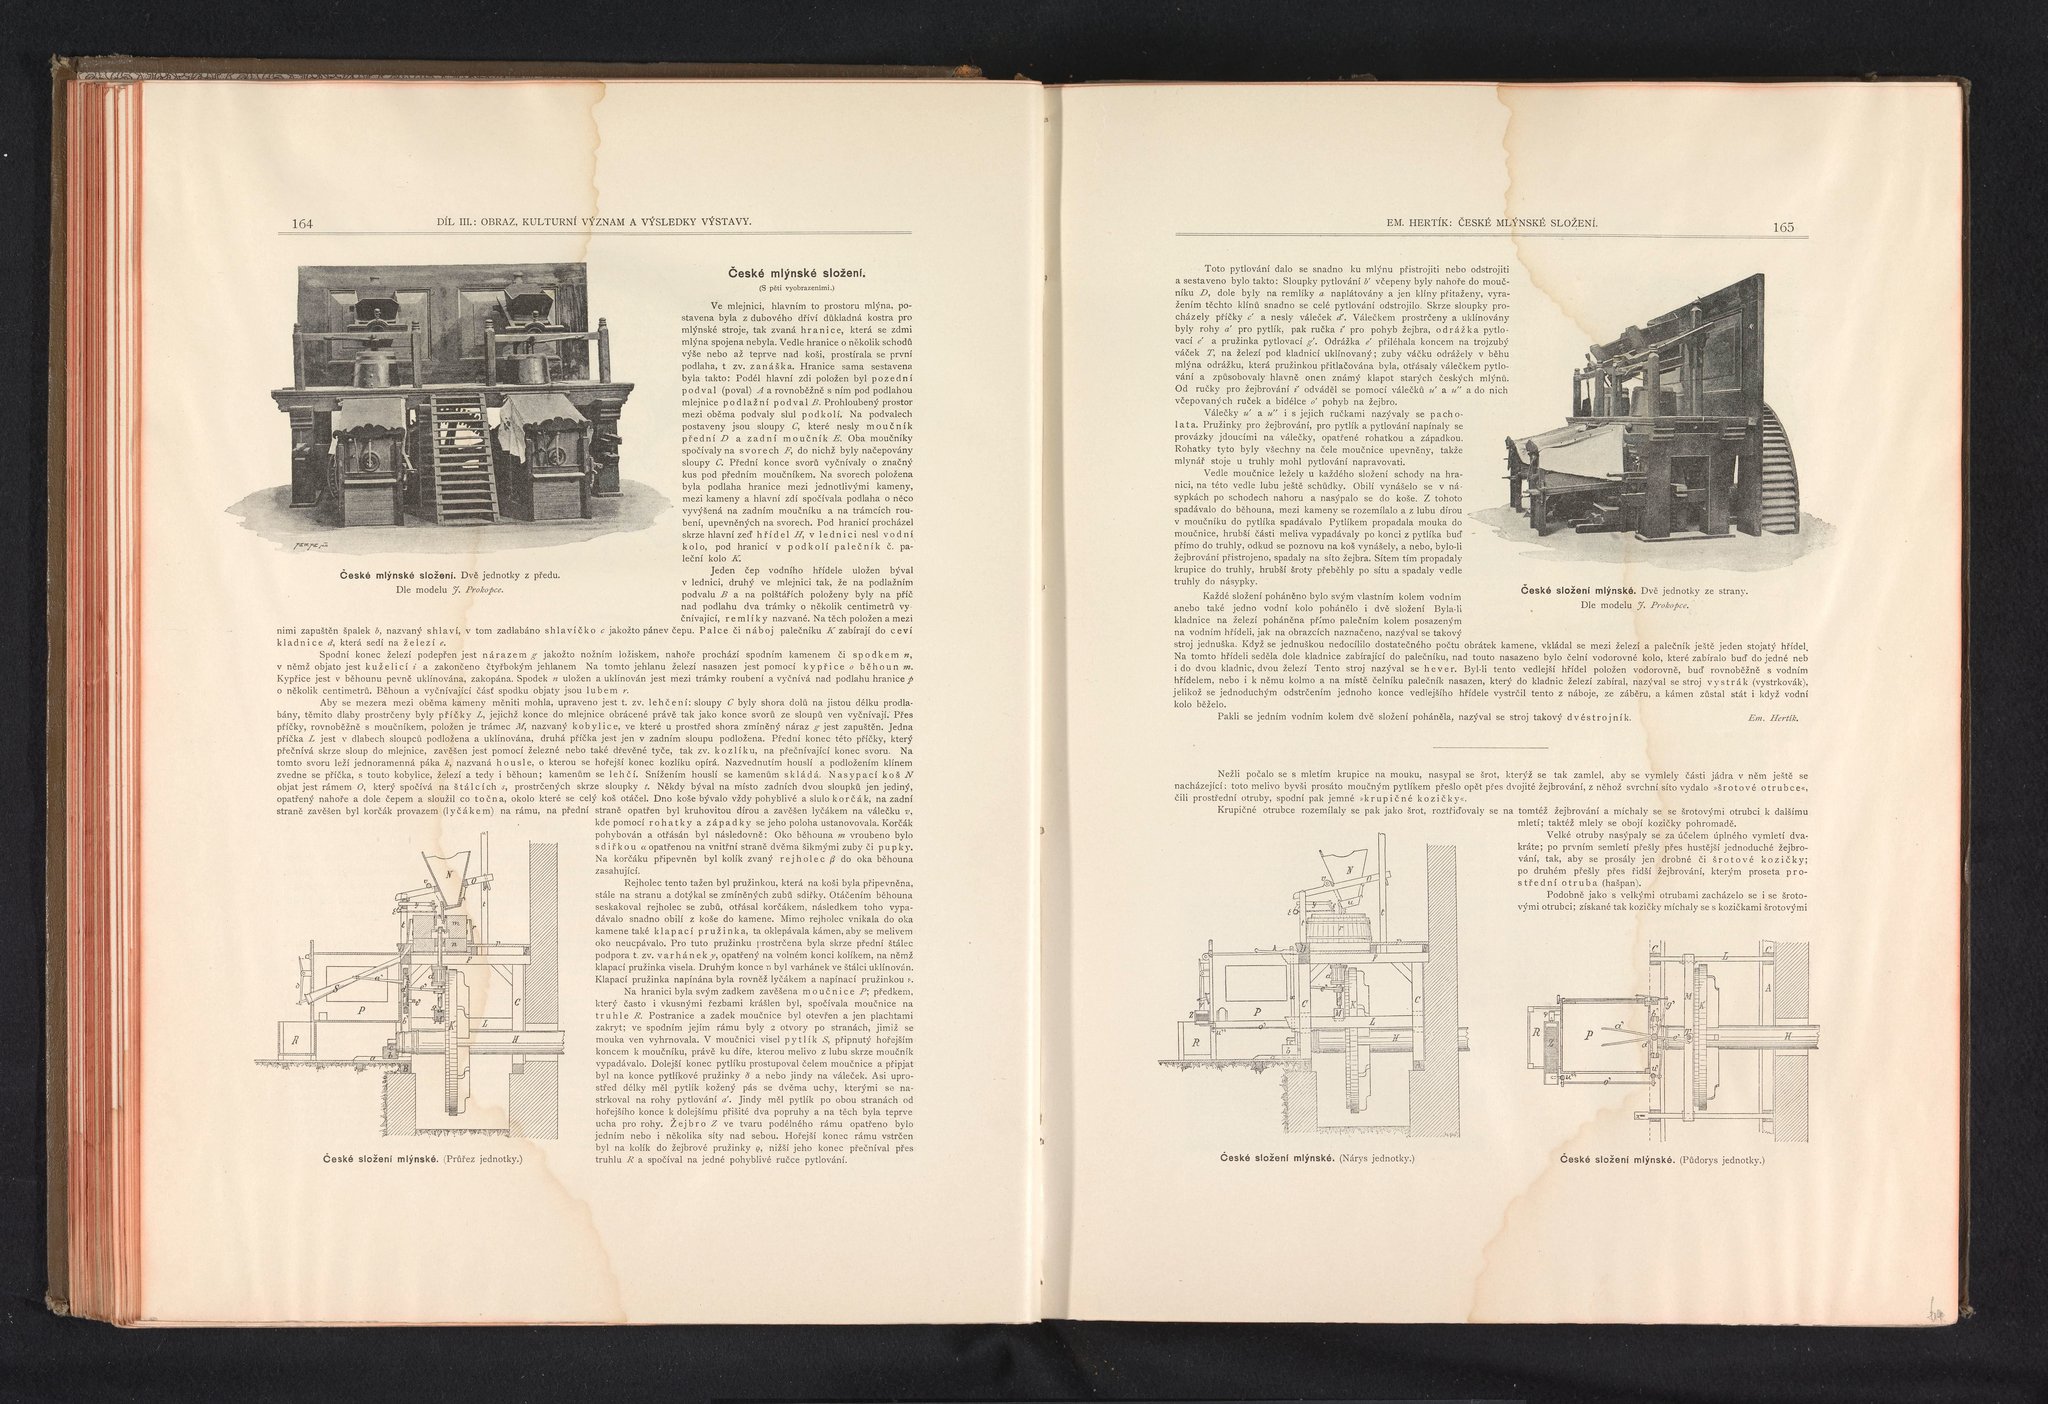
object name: photomechanical print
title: Tsjechische graanmolen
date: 1890-1895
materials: paper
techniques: autotype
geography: prague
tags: grinding, milling (industrial processes)